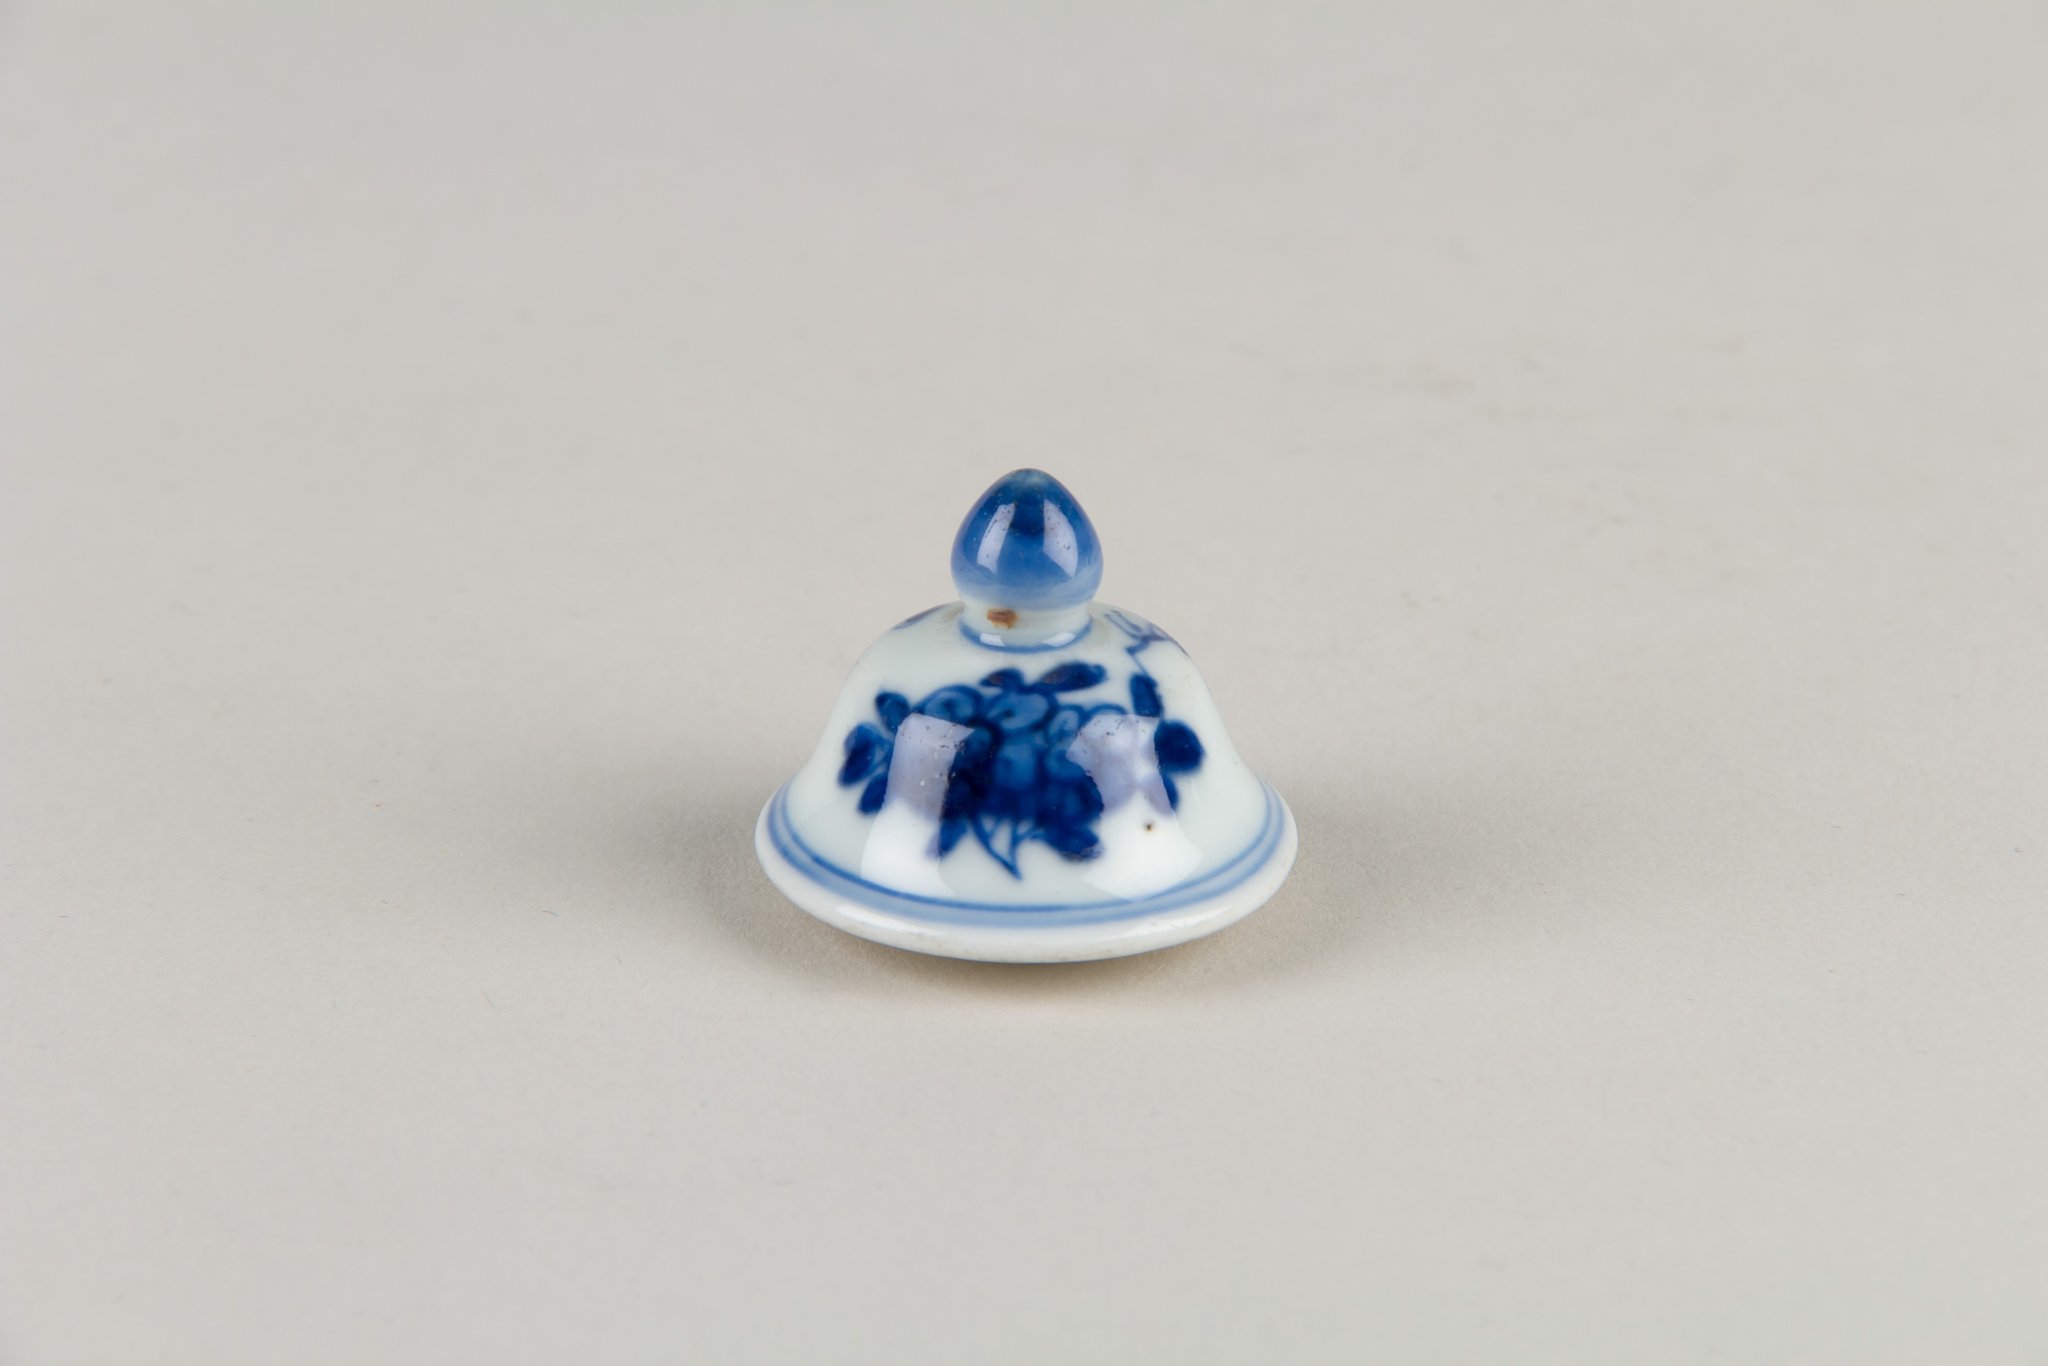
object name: cover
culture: chinese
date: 1662-1722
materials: porcelain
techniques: painting, underglaze